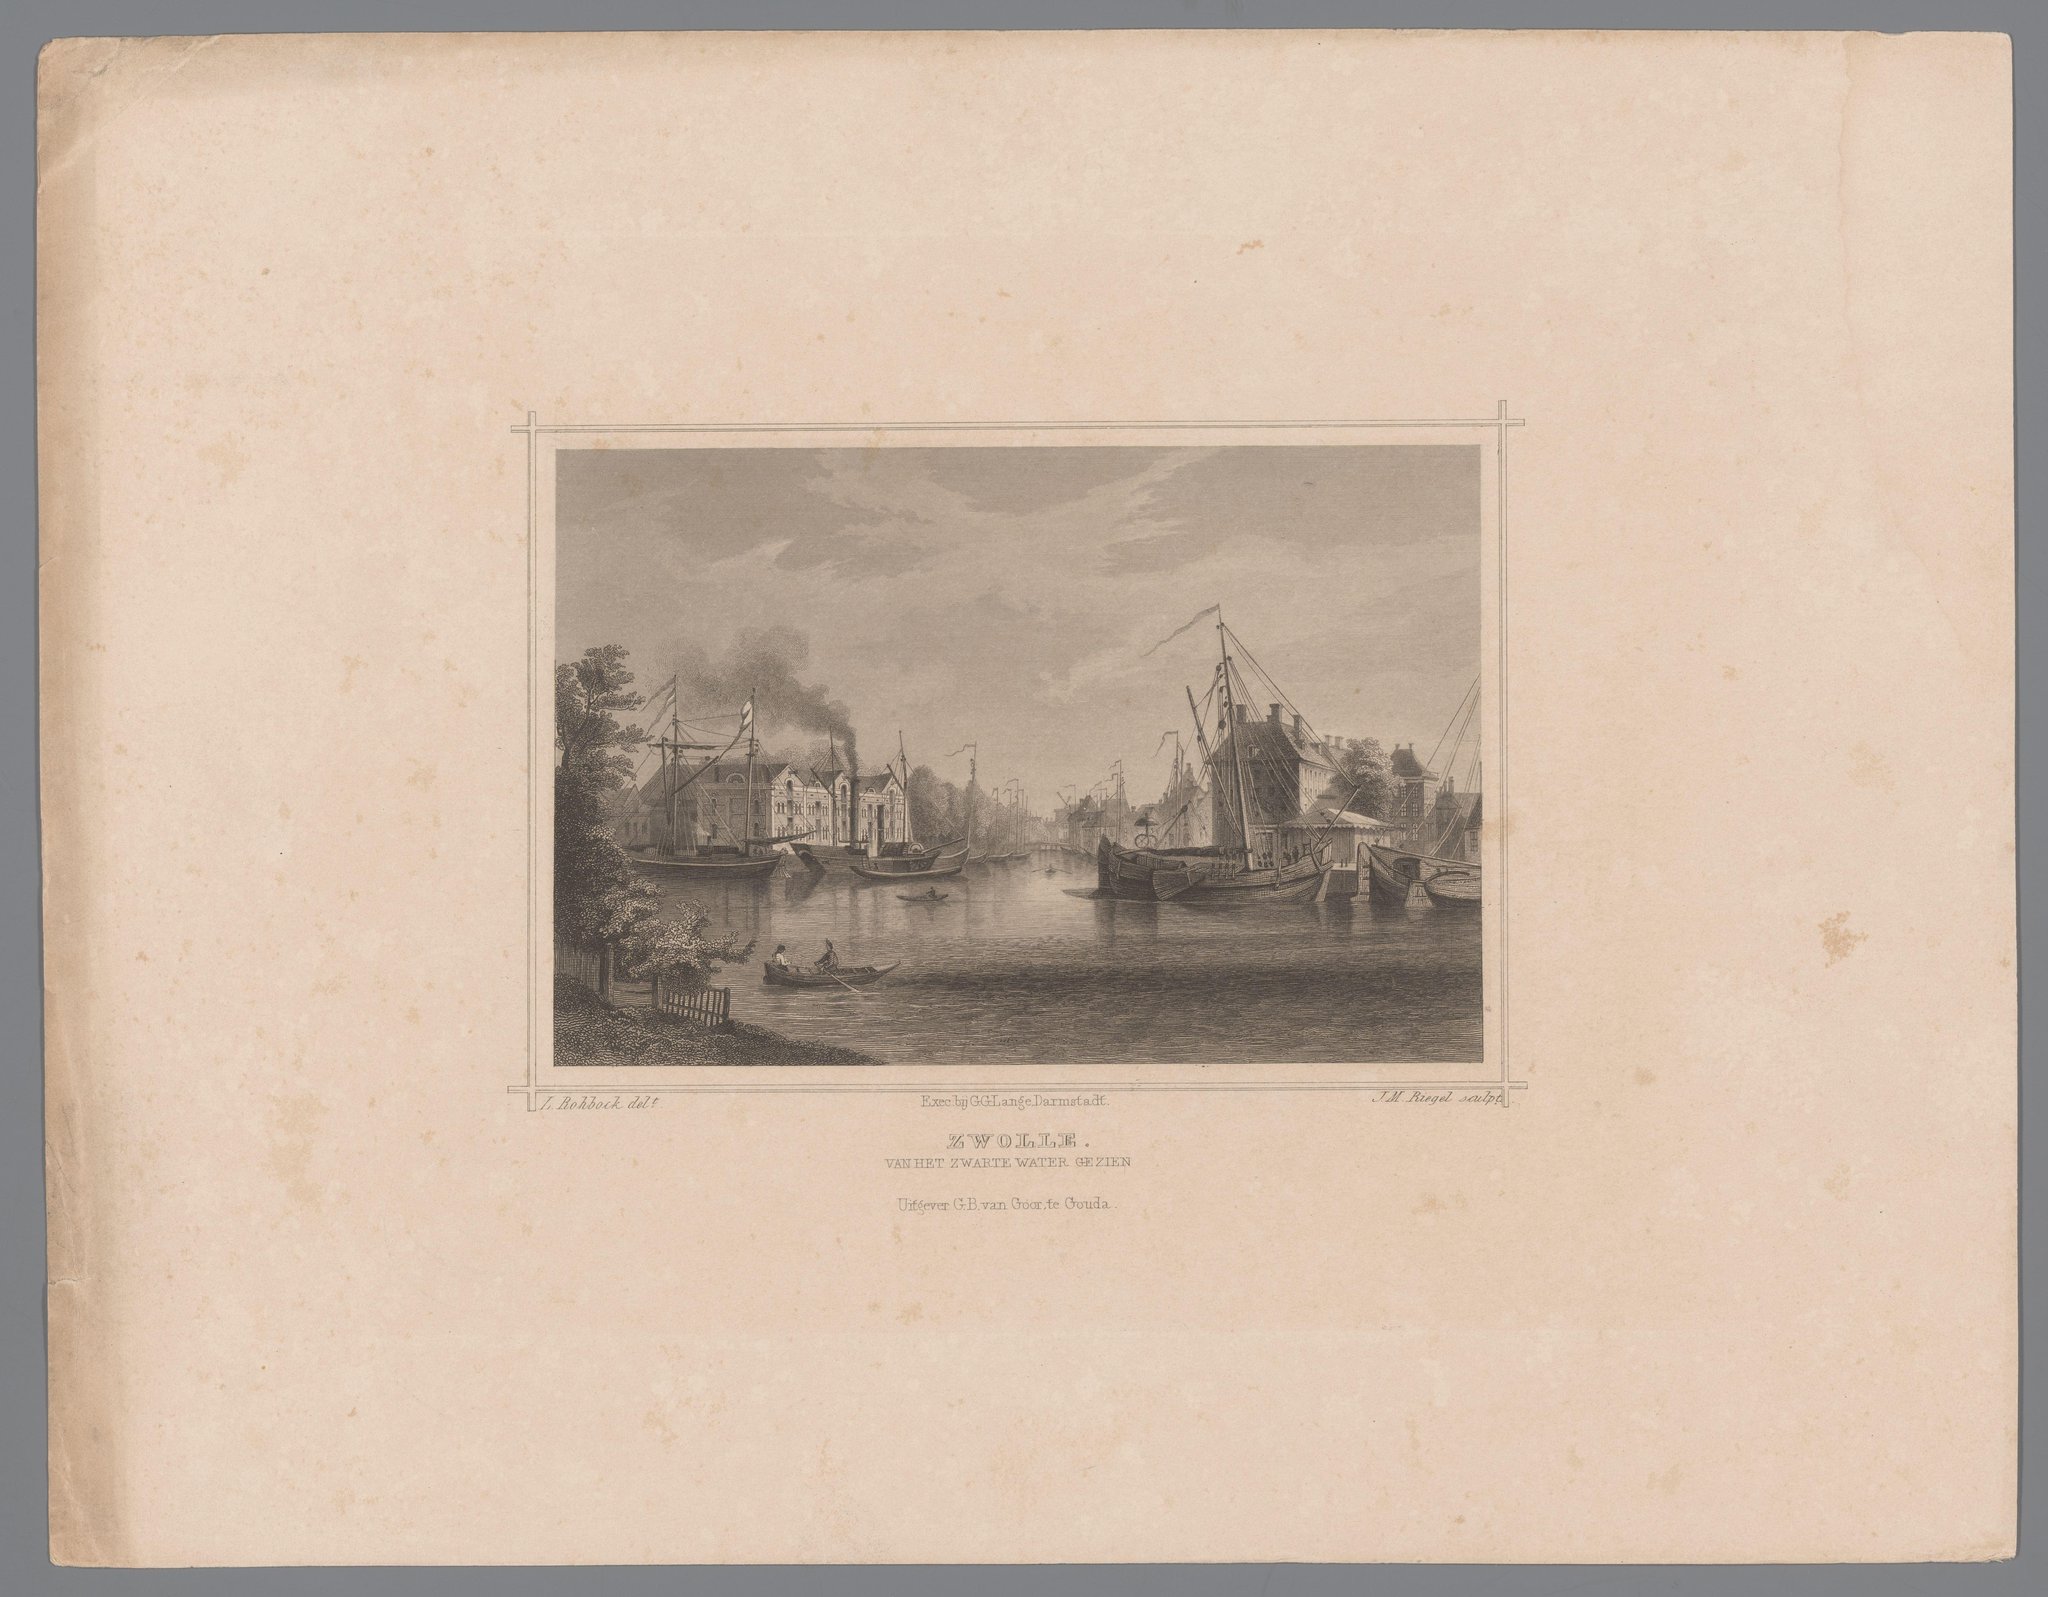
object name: book illustration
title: Gezicht op Zwolle vanaf het Zwarte Water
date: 1855-1858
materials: paper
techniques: engraving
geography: gouda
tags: city-view, and landscape with man-made constructions, river, ships (in general) - cc - more than one ship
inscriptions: collector's mark: Lugt 2228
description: Prent uit: Terwen, Johannes Leonardus. Het Koningrijk der Nederlanden voorgesteld in eene reeks van naar de natuur geteekende schilderachtige gezigten. Gouda: G.B. van Goor, 1855-1858.